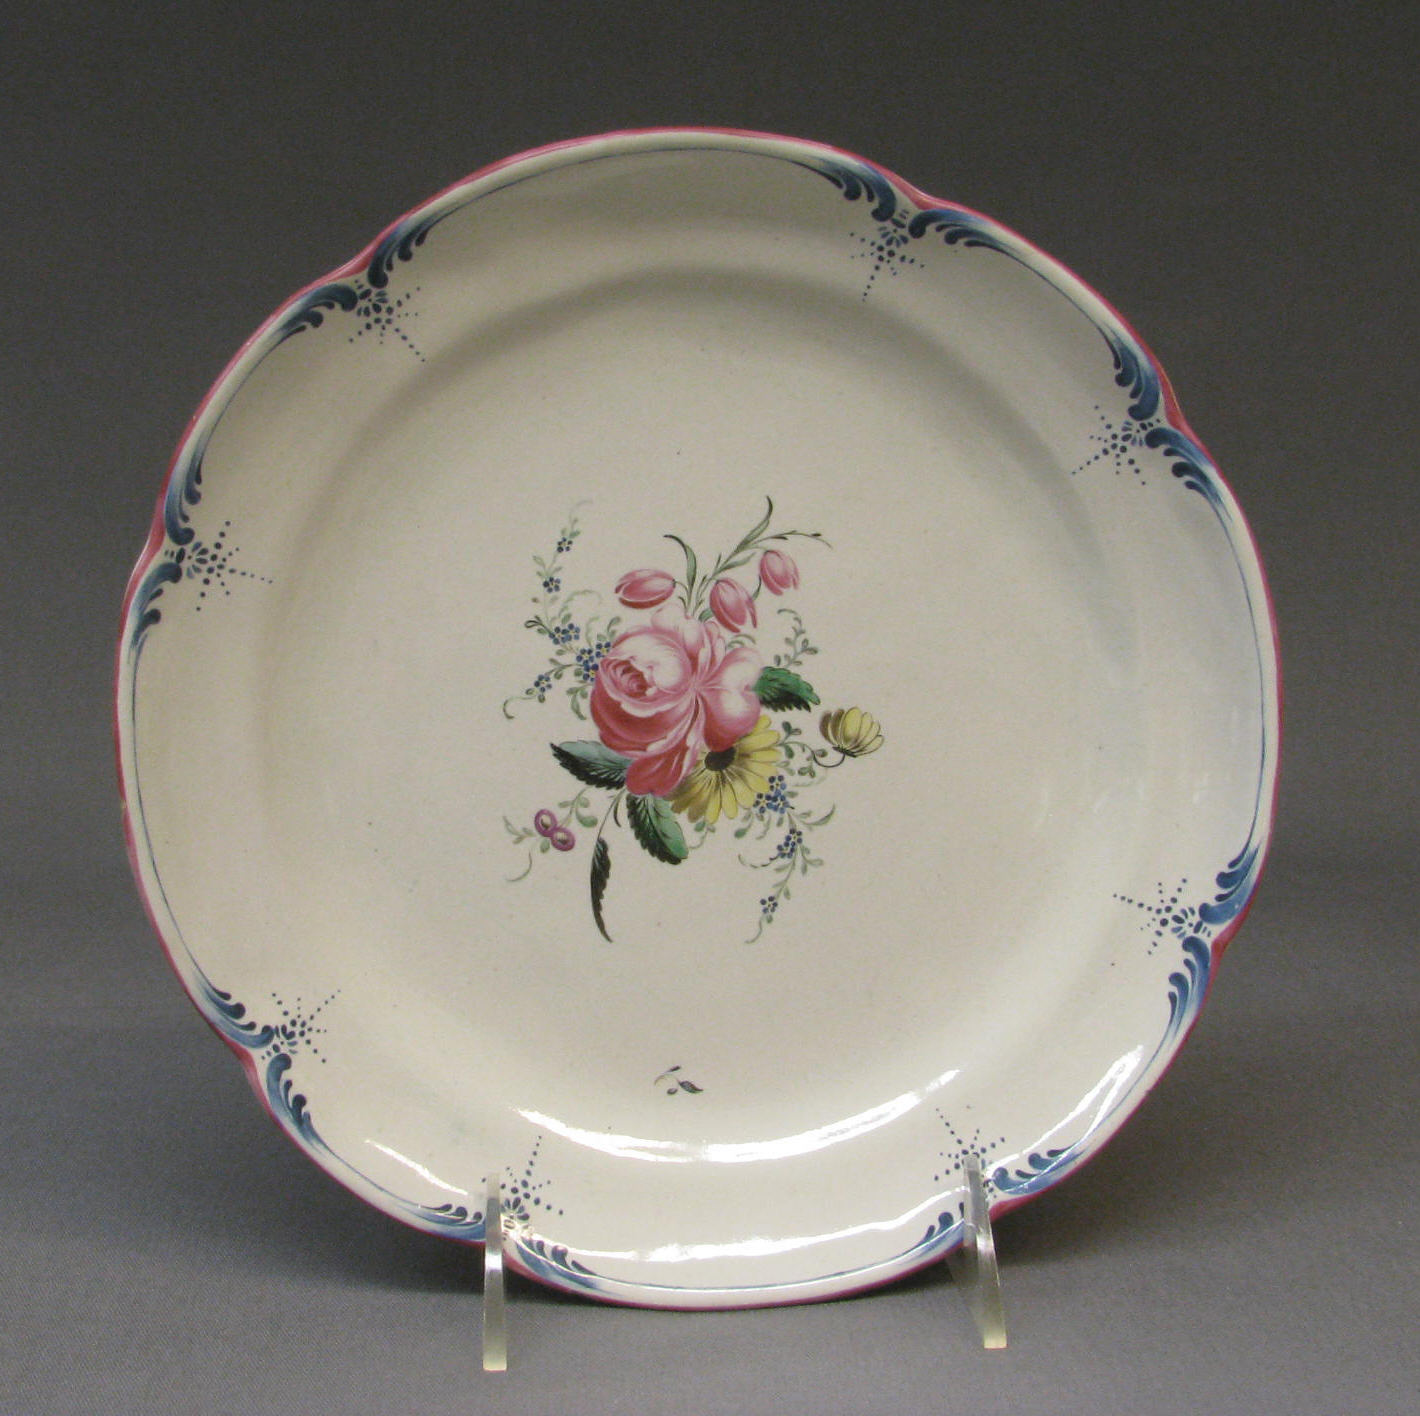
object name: plate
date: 1751-1800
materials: faience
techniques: glazing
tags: flowers